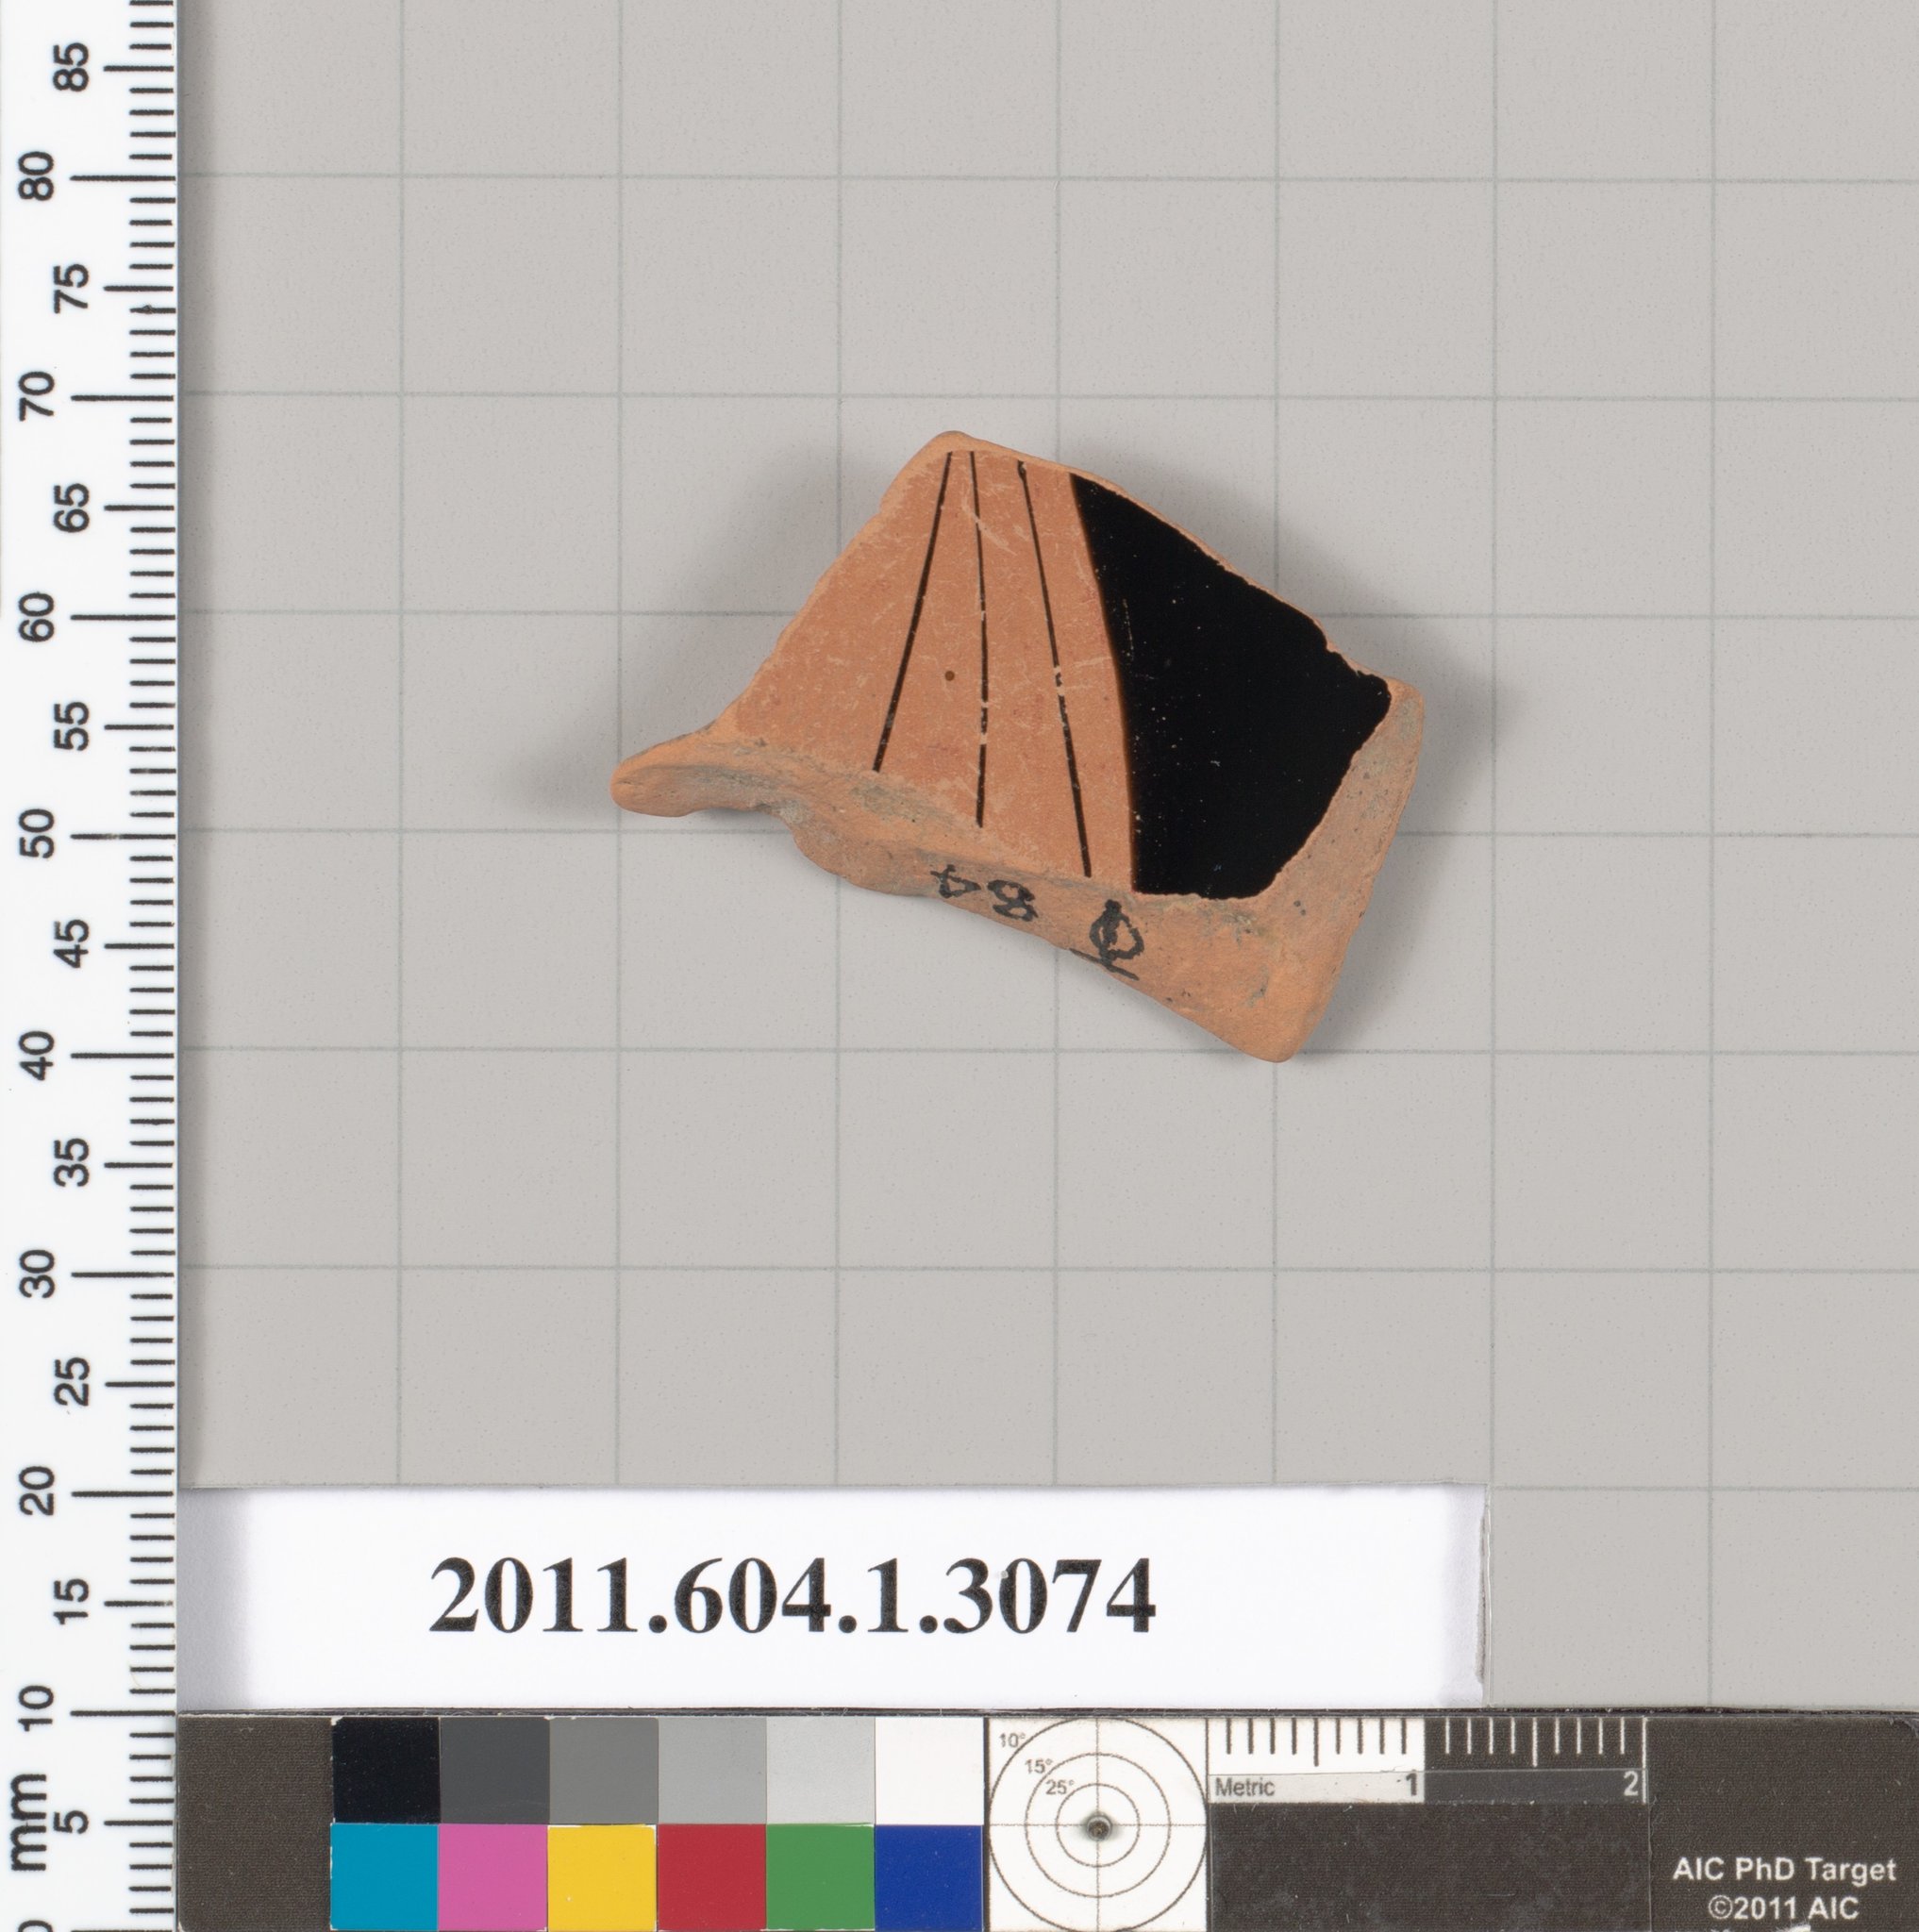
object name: kylix fragment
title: Terracotta fragment of a kylix (drinking cup)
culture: greek, attic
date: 475-451 BCE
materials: terracotta